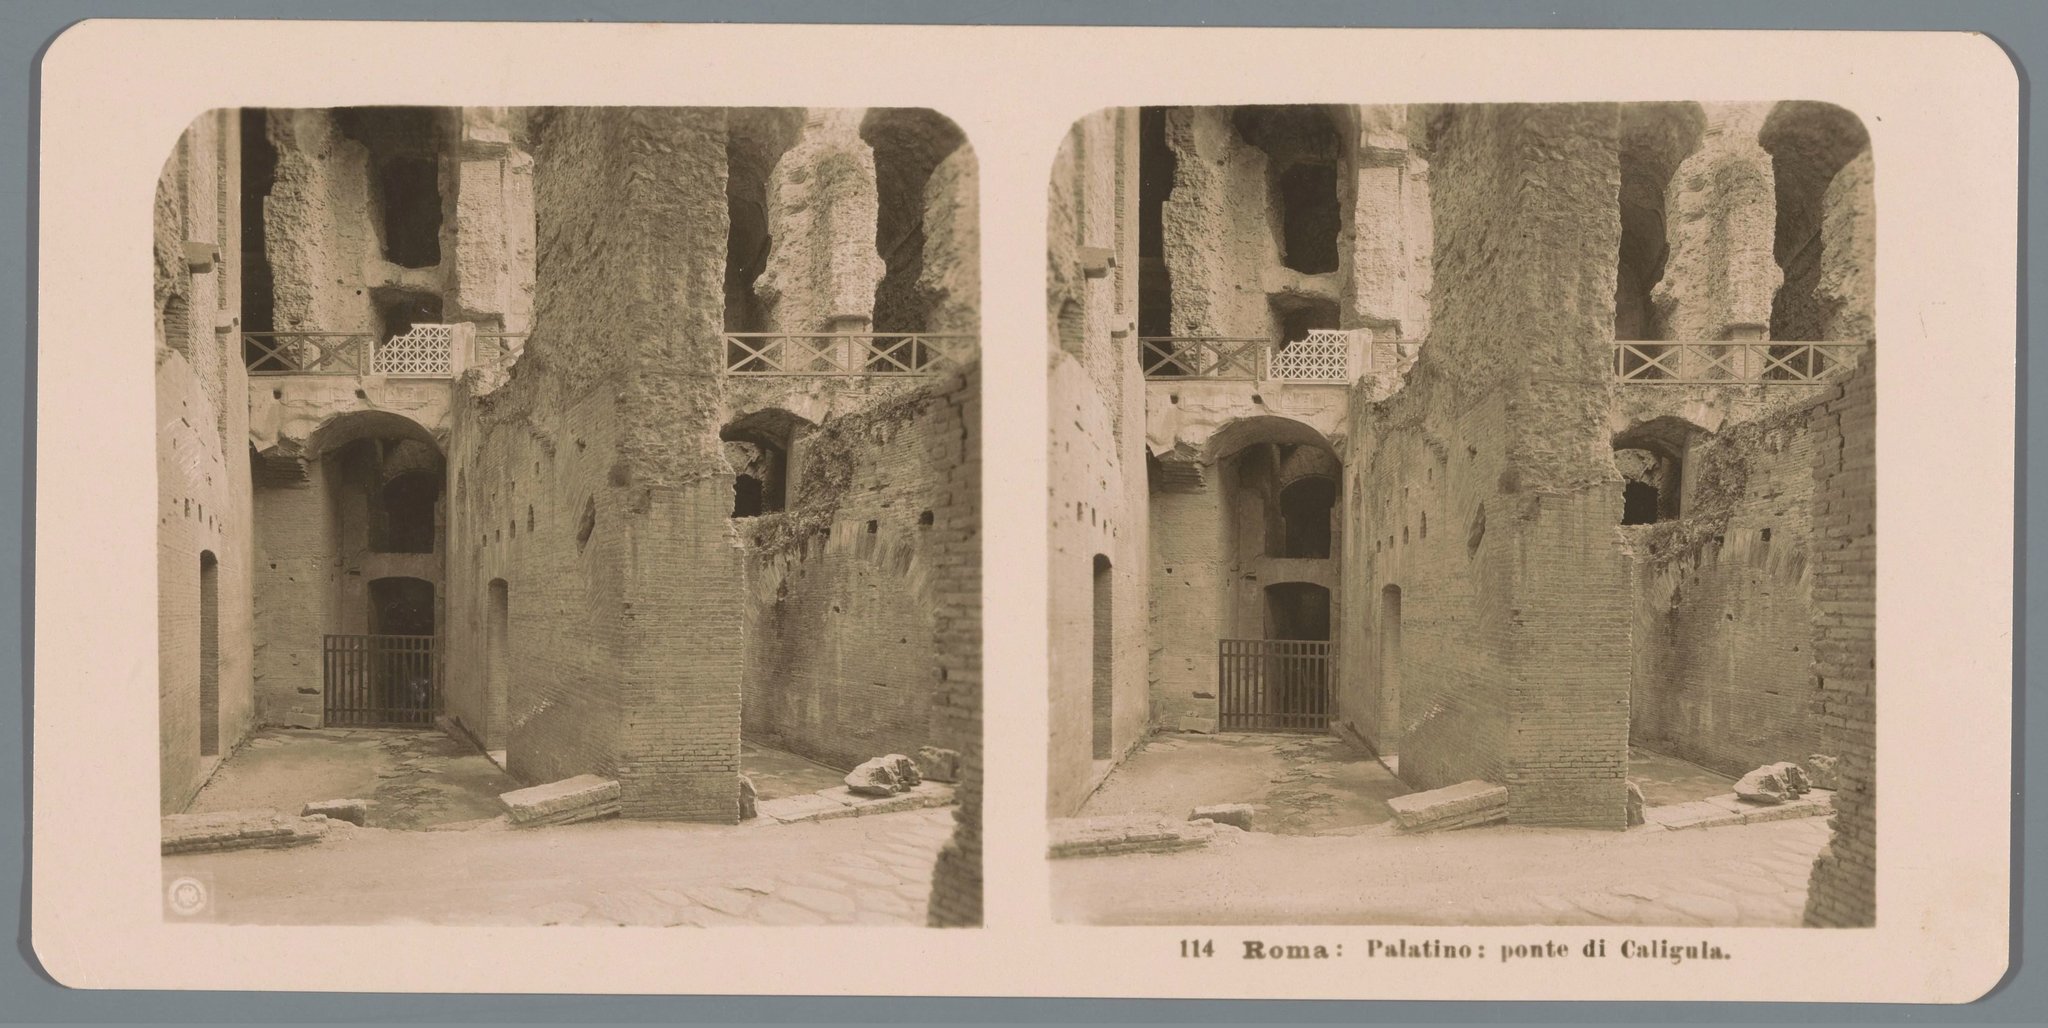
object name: stereograph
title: Ruïne van de Ponte di Caligula te Rome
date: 1900-1910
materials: cardboard, photographic support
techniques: gelatin silver print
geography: rome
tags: ruin of a building ~ architecture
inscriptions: number: ‘114’, inscription: ‘NPG’